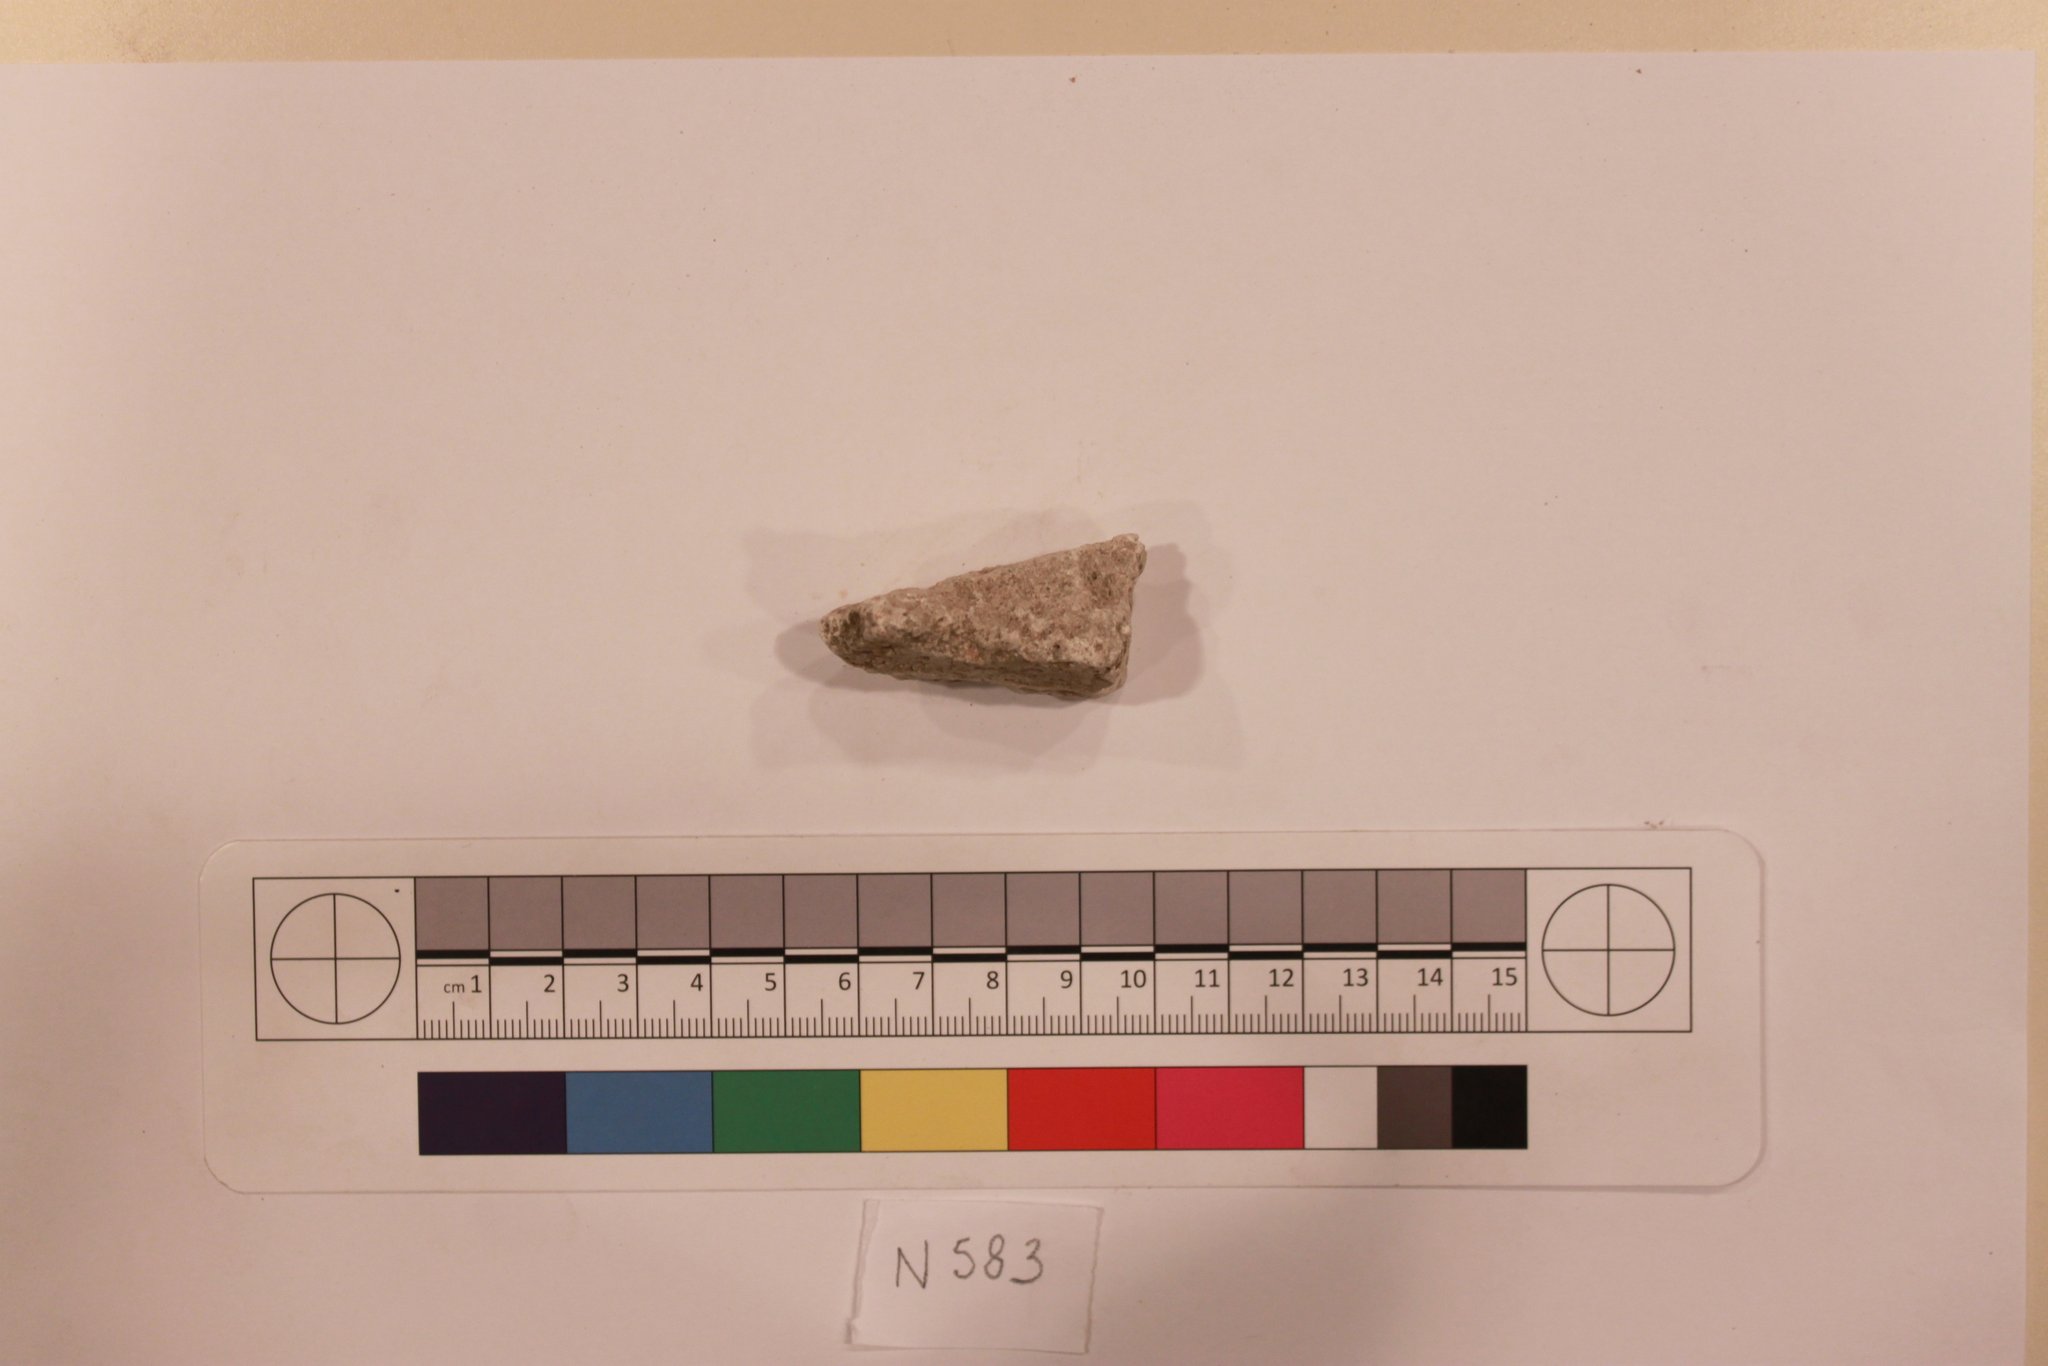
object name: fragment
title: Stucco Fragment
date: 701-1200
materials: plaster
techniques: carving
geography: iran